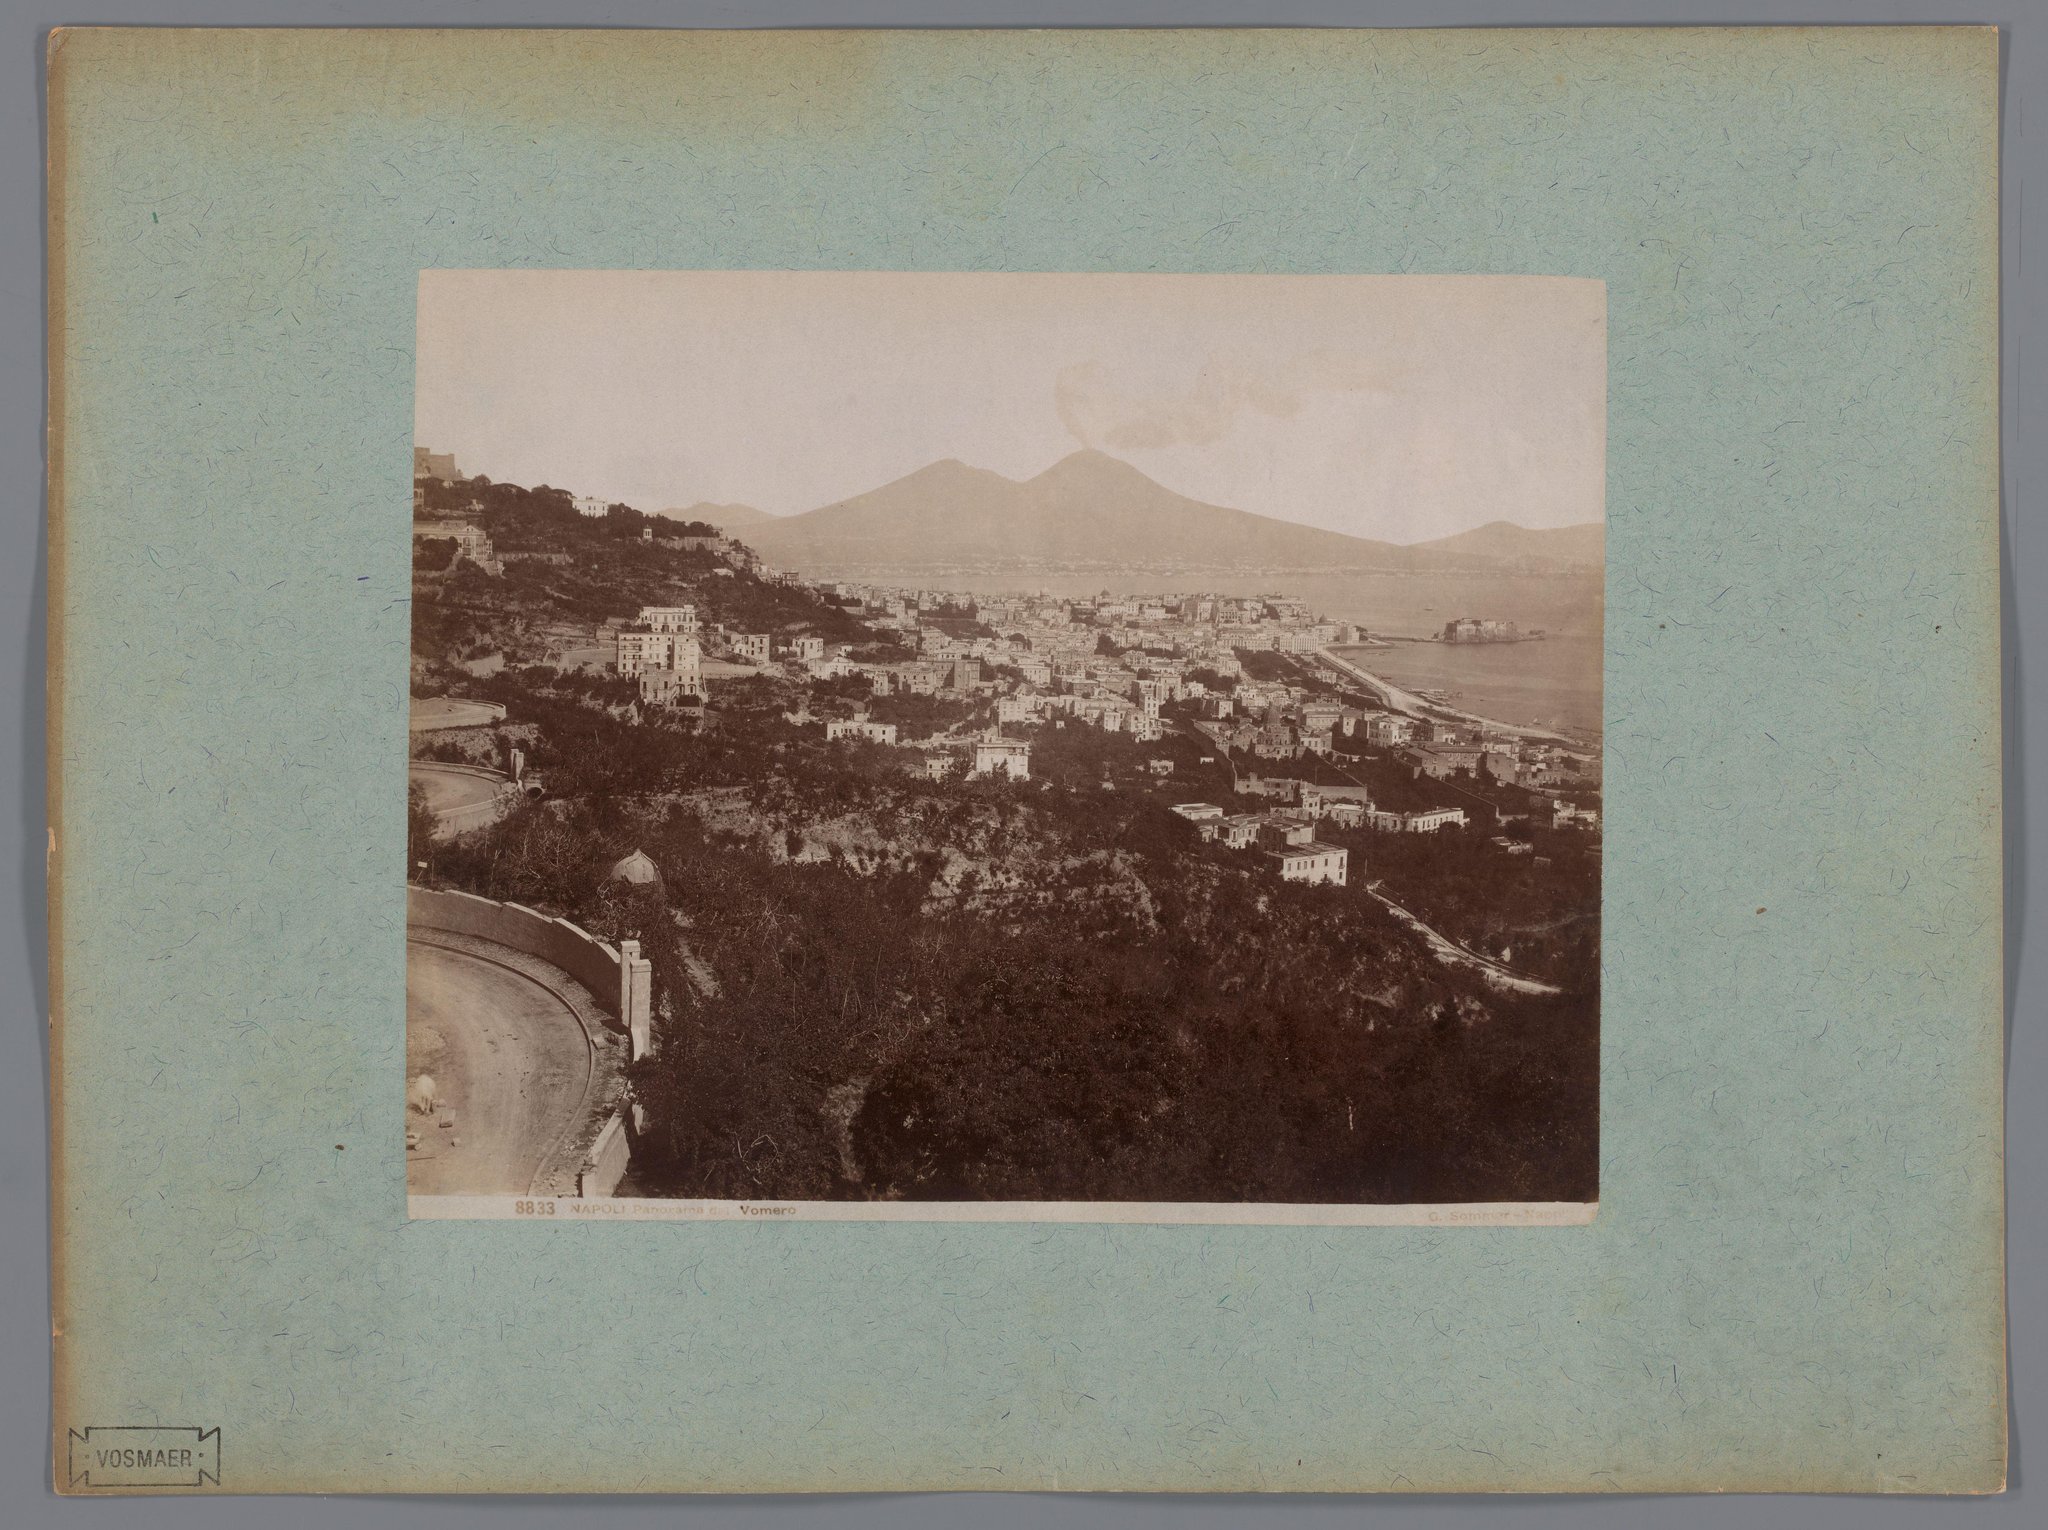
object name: photograph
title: Gezicht op Napels en de Vesuvius vanaf de wijk Vomero, Italië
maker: giorgio sommer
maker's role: fotograaf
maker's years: 1834-1914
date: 1857-1914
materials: cardboard, paper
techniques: albumen print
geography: naples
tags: city-view in general; 'veduta', volcano, mount vesuvius, naples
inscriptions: collector's mark: ‘VOSMAER’, number: ‘8833’